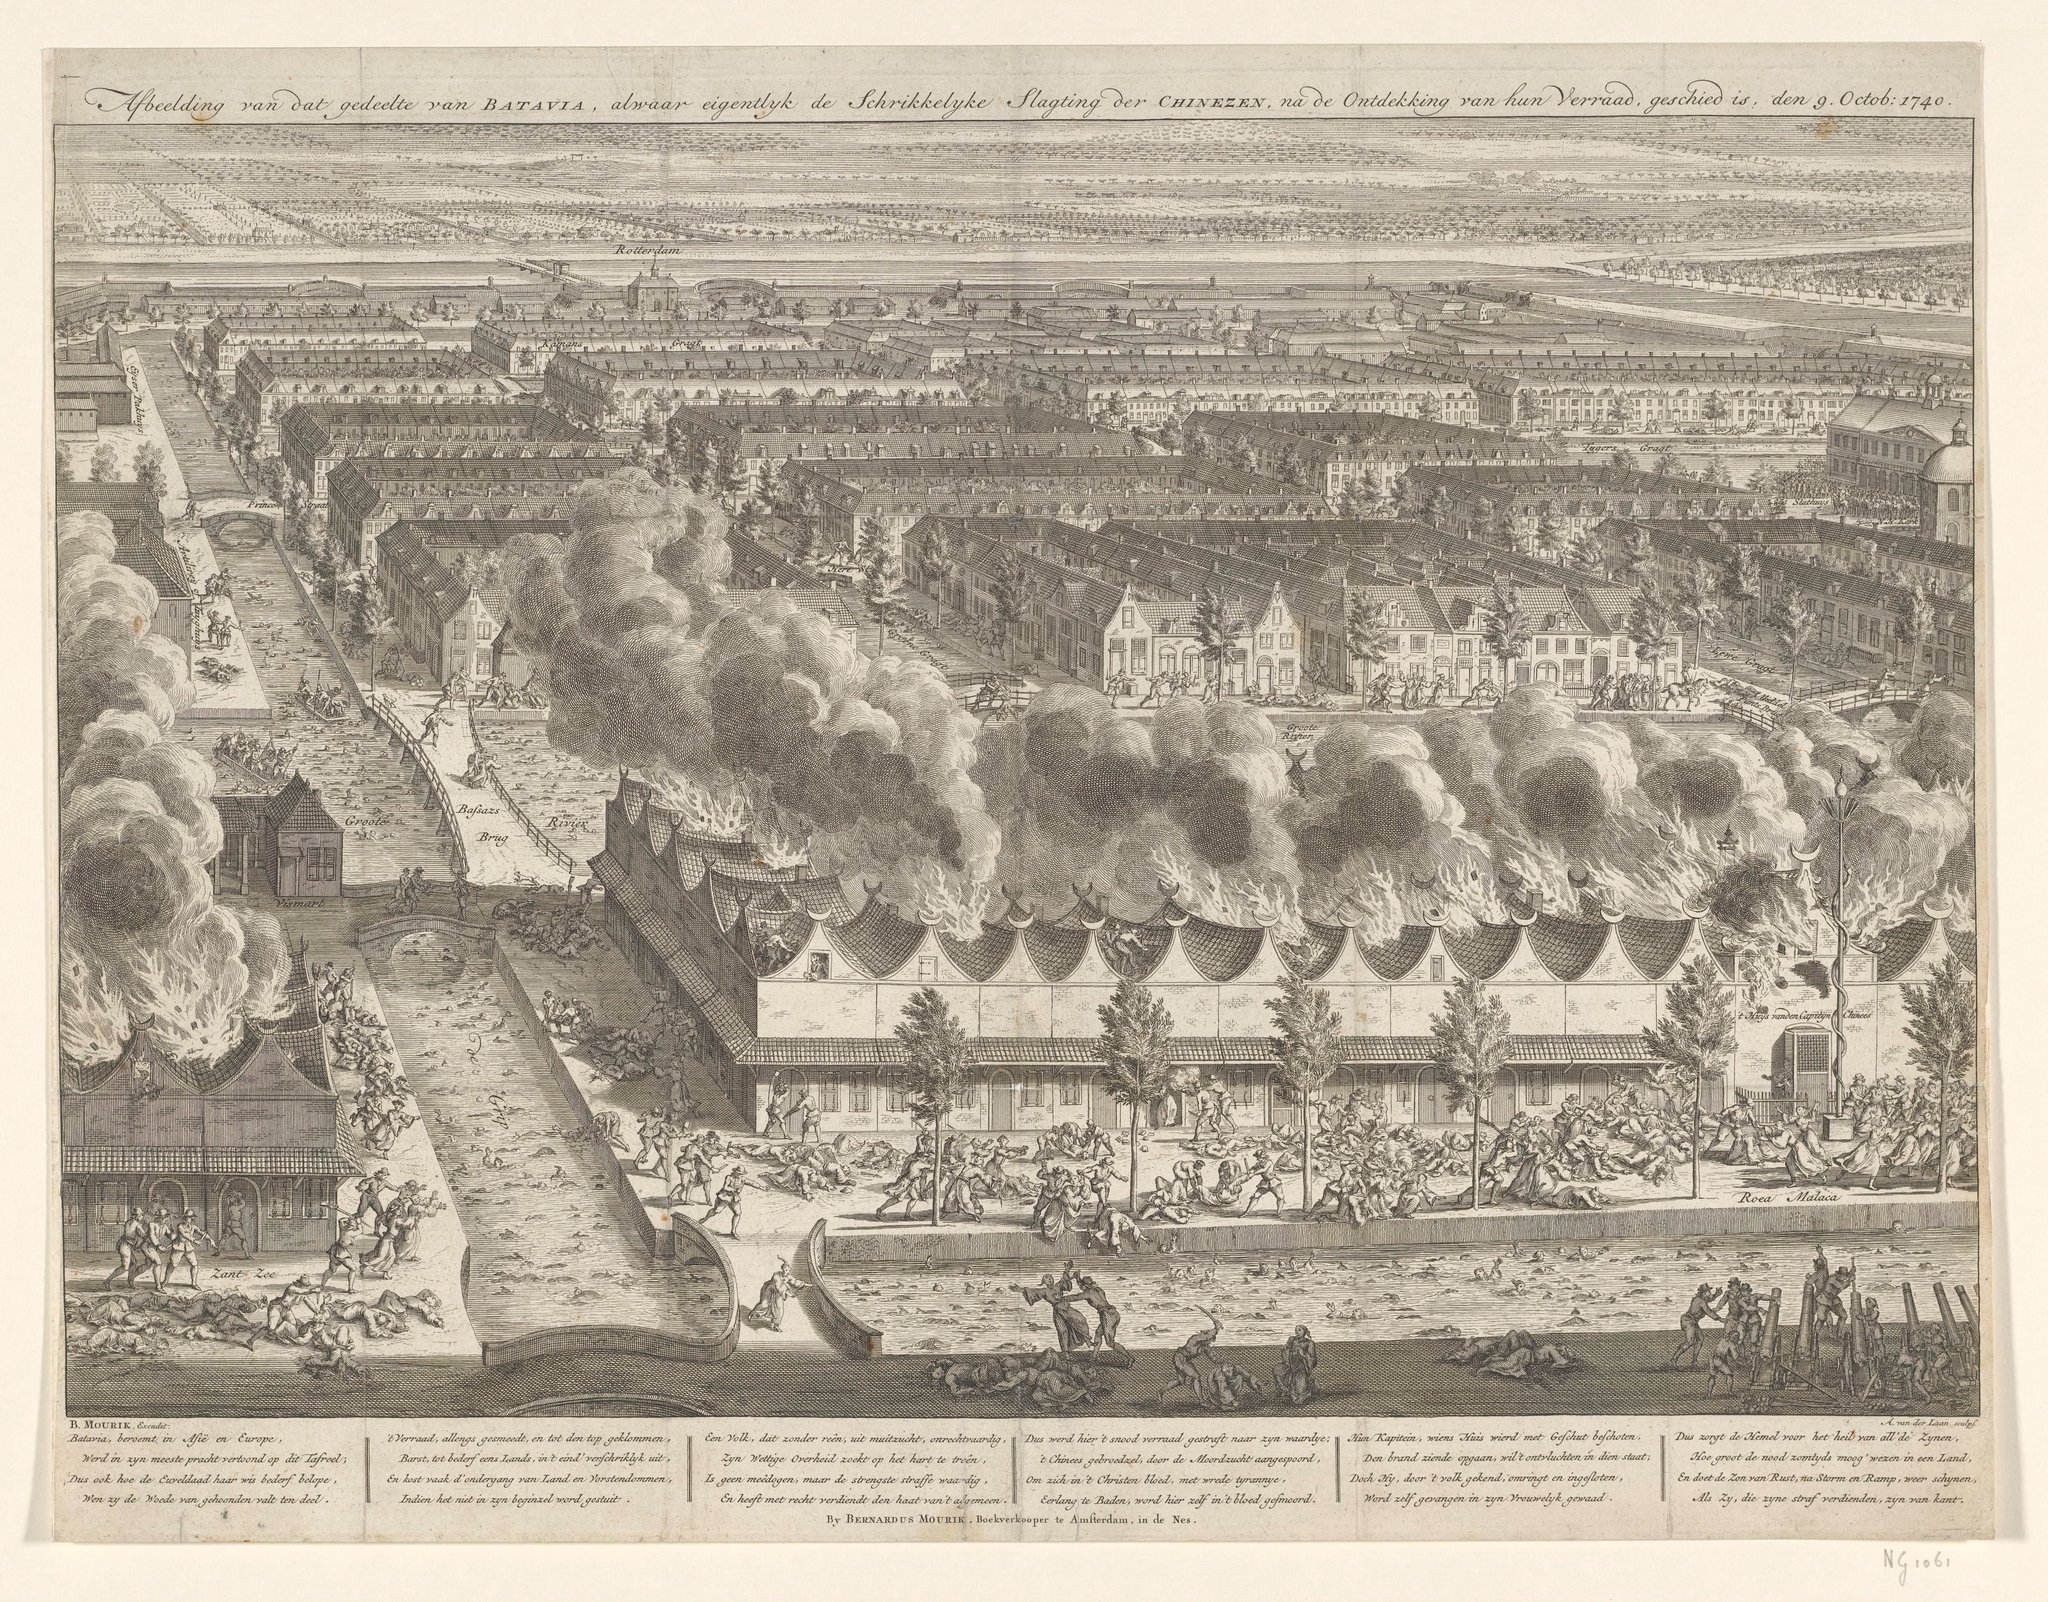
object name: print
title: Afbeelding van dat gedeelte van BATAVIA, alwaar eigentlyk de Schrikkelyke Slagting der CHINEZEN, na de Ontdekking van hun Verraad, geschied is, den 9. Octob: 1740.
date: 1741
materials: paper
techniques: engraving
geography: amsterdam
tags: massacre ~ war, batavia